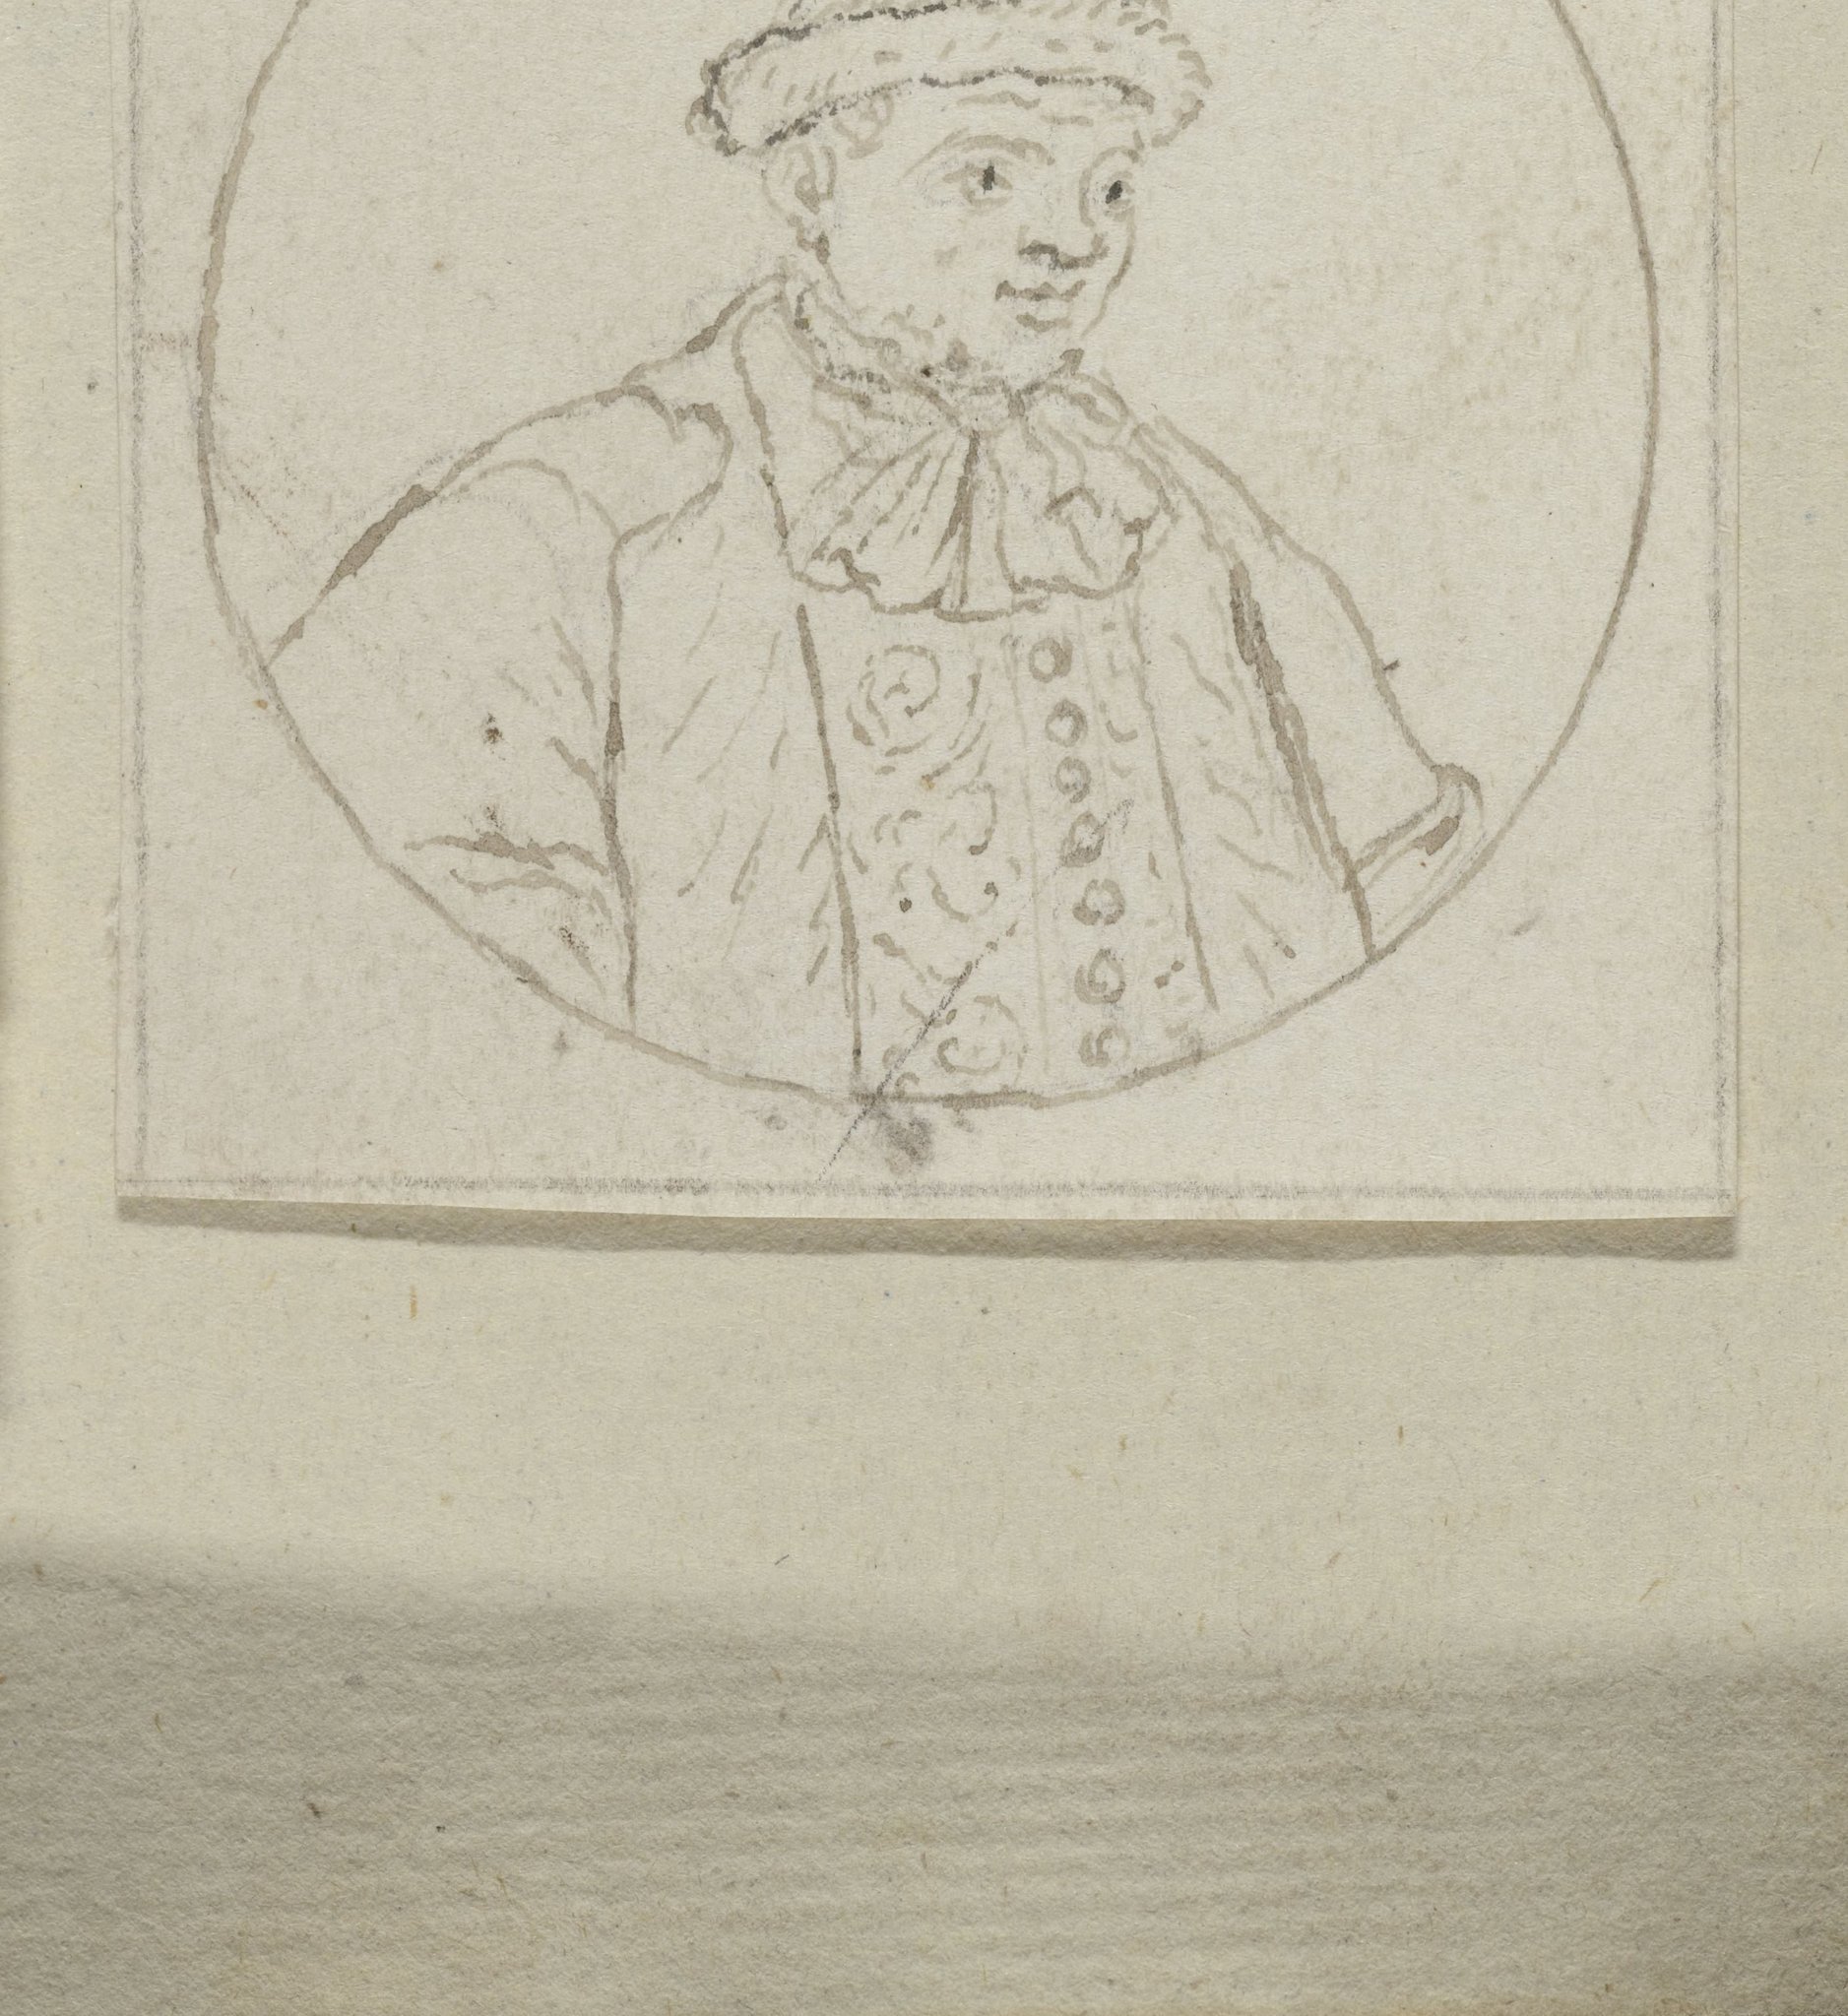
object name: drawing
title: Buste van een man met muts in een cirkel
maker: Anonymous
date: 1700-1799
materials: ink, paper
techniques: pen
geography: netherlands